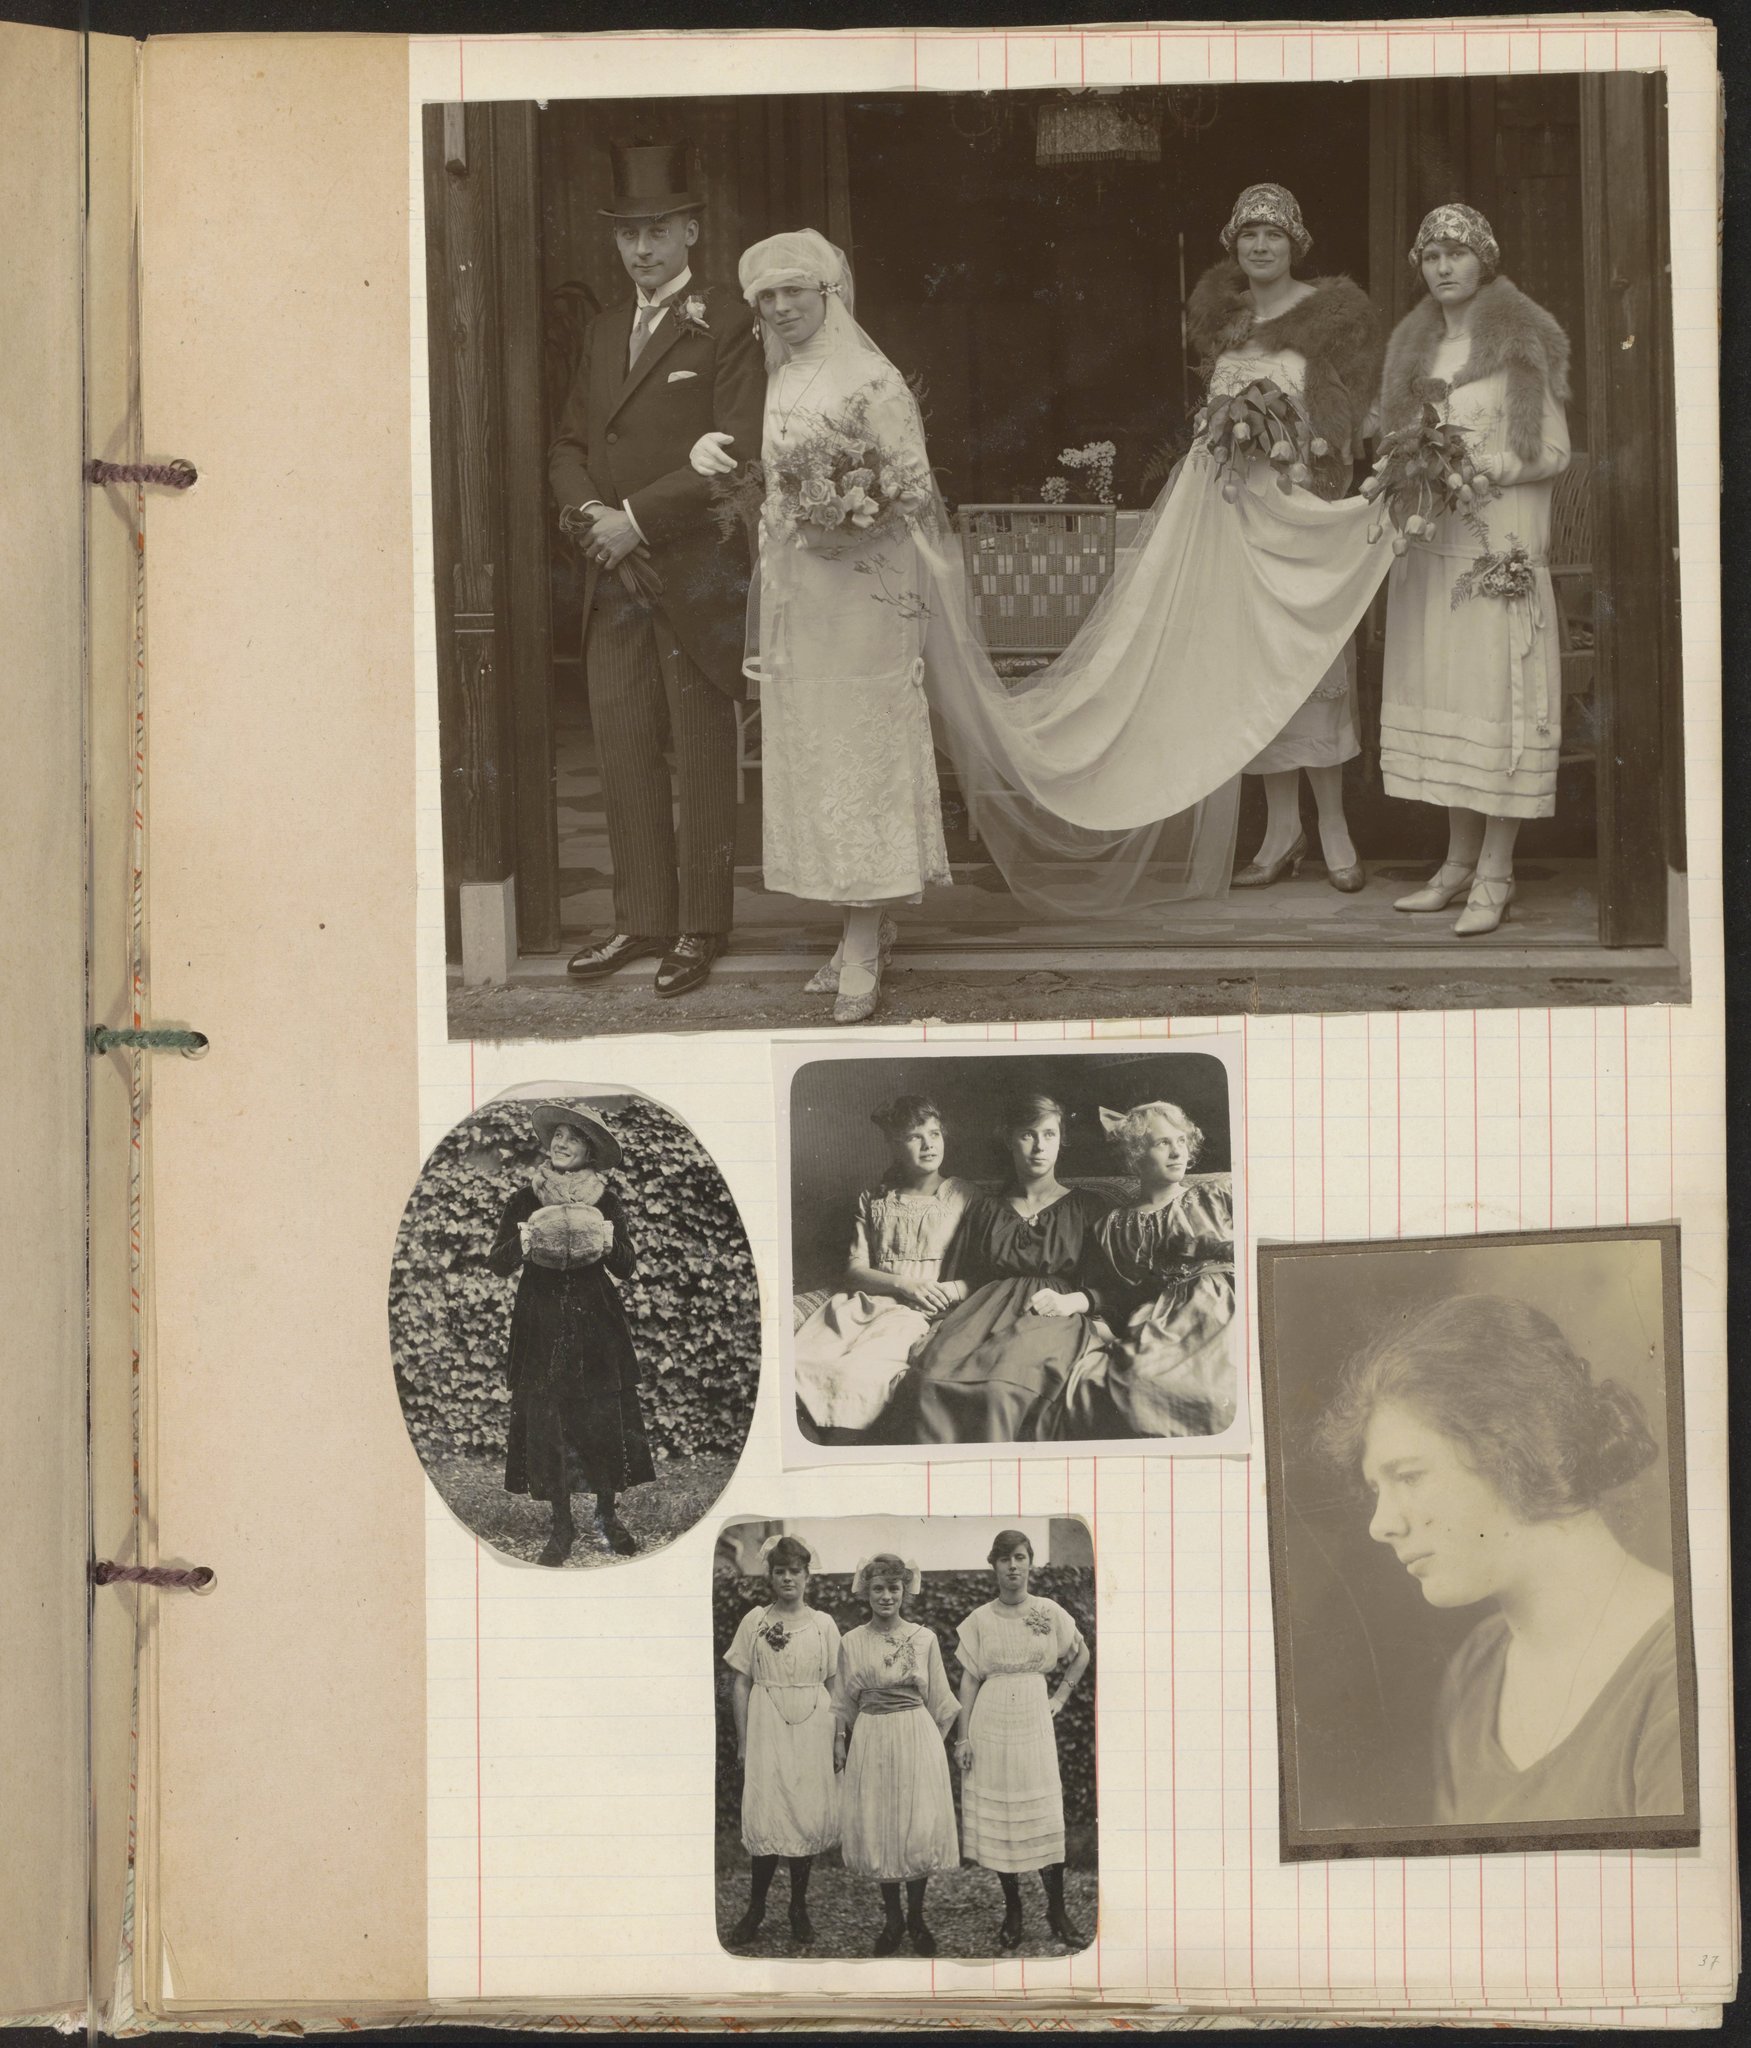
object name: album leaf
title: Portretten van onbekende personen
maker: Anonymous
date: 1910-1930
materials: paper, photographic support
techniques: gelatin silver print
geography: netherlands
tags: adult woman, adult man, marriage, married couple, 'matrimonium', muff (+ fur used for clothes)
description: Albumblad met portretten van een bruidspaar met bruidsmeisjes en van jonge vrouwen. Onderdeel van Fotoalbum van de familie Petri.